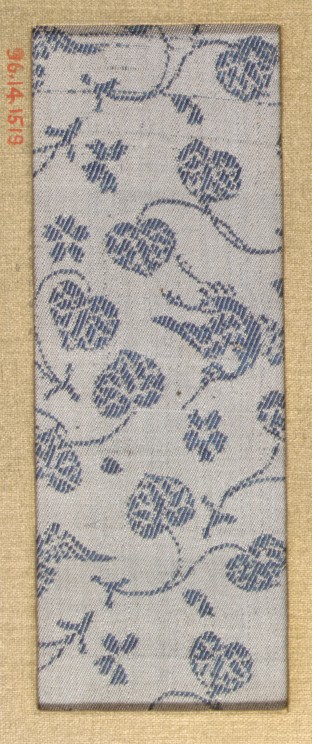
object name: piece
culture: japanese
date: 1701-1900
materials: silk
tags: birds